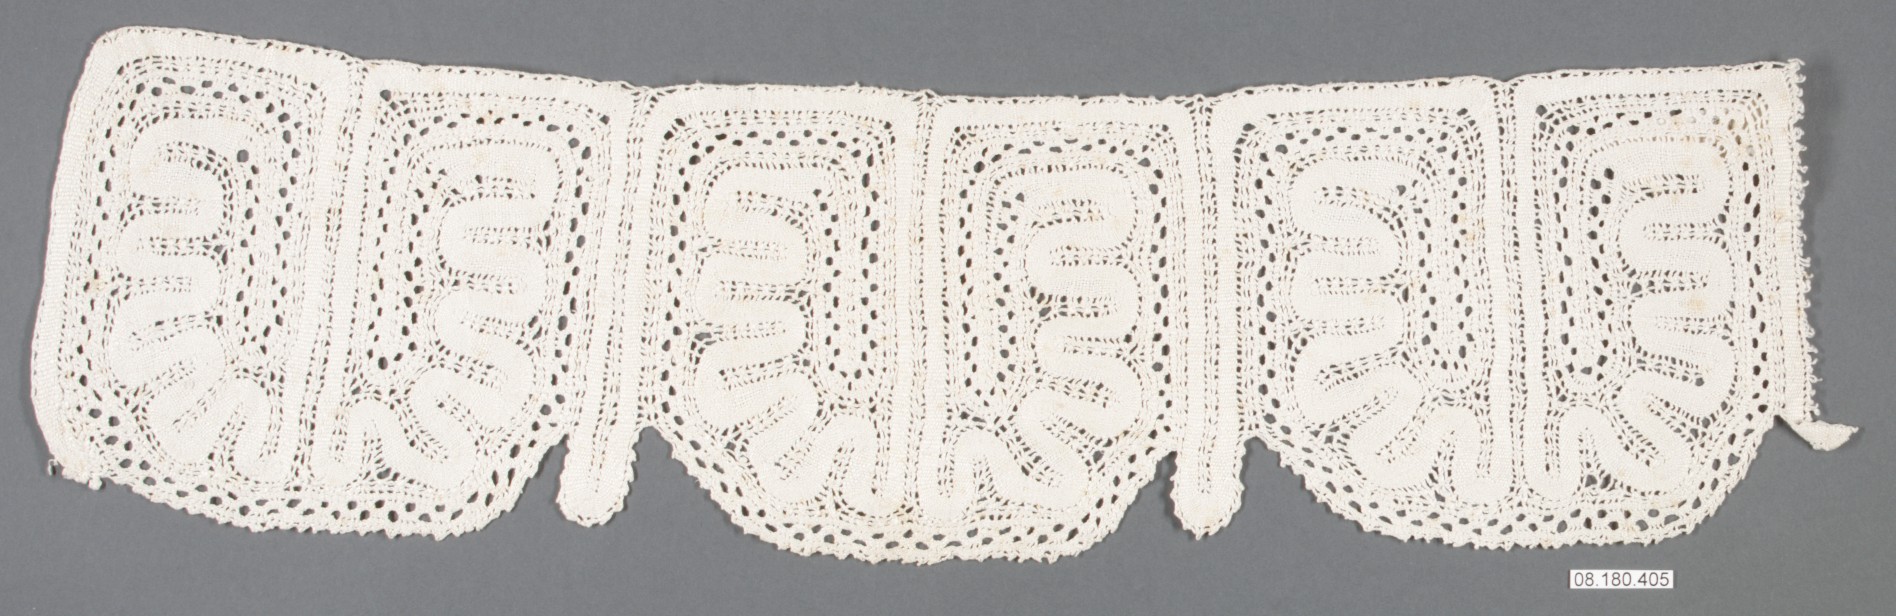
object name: piece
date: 1701-1800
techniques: lace